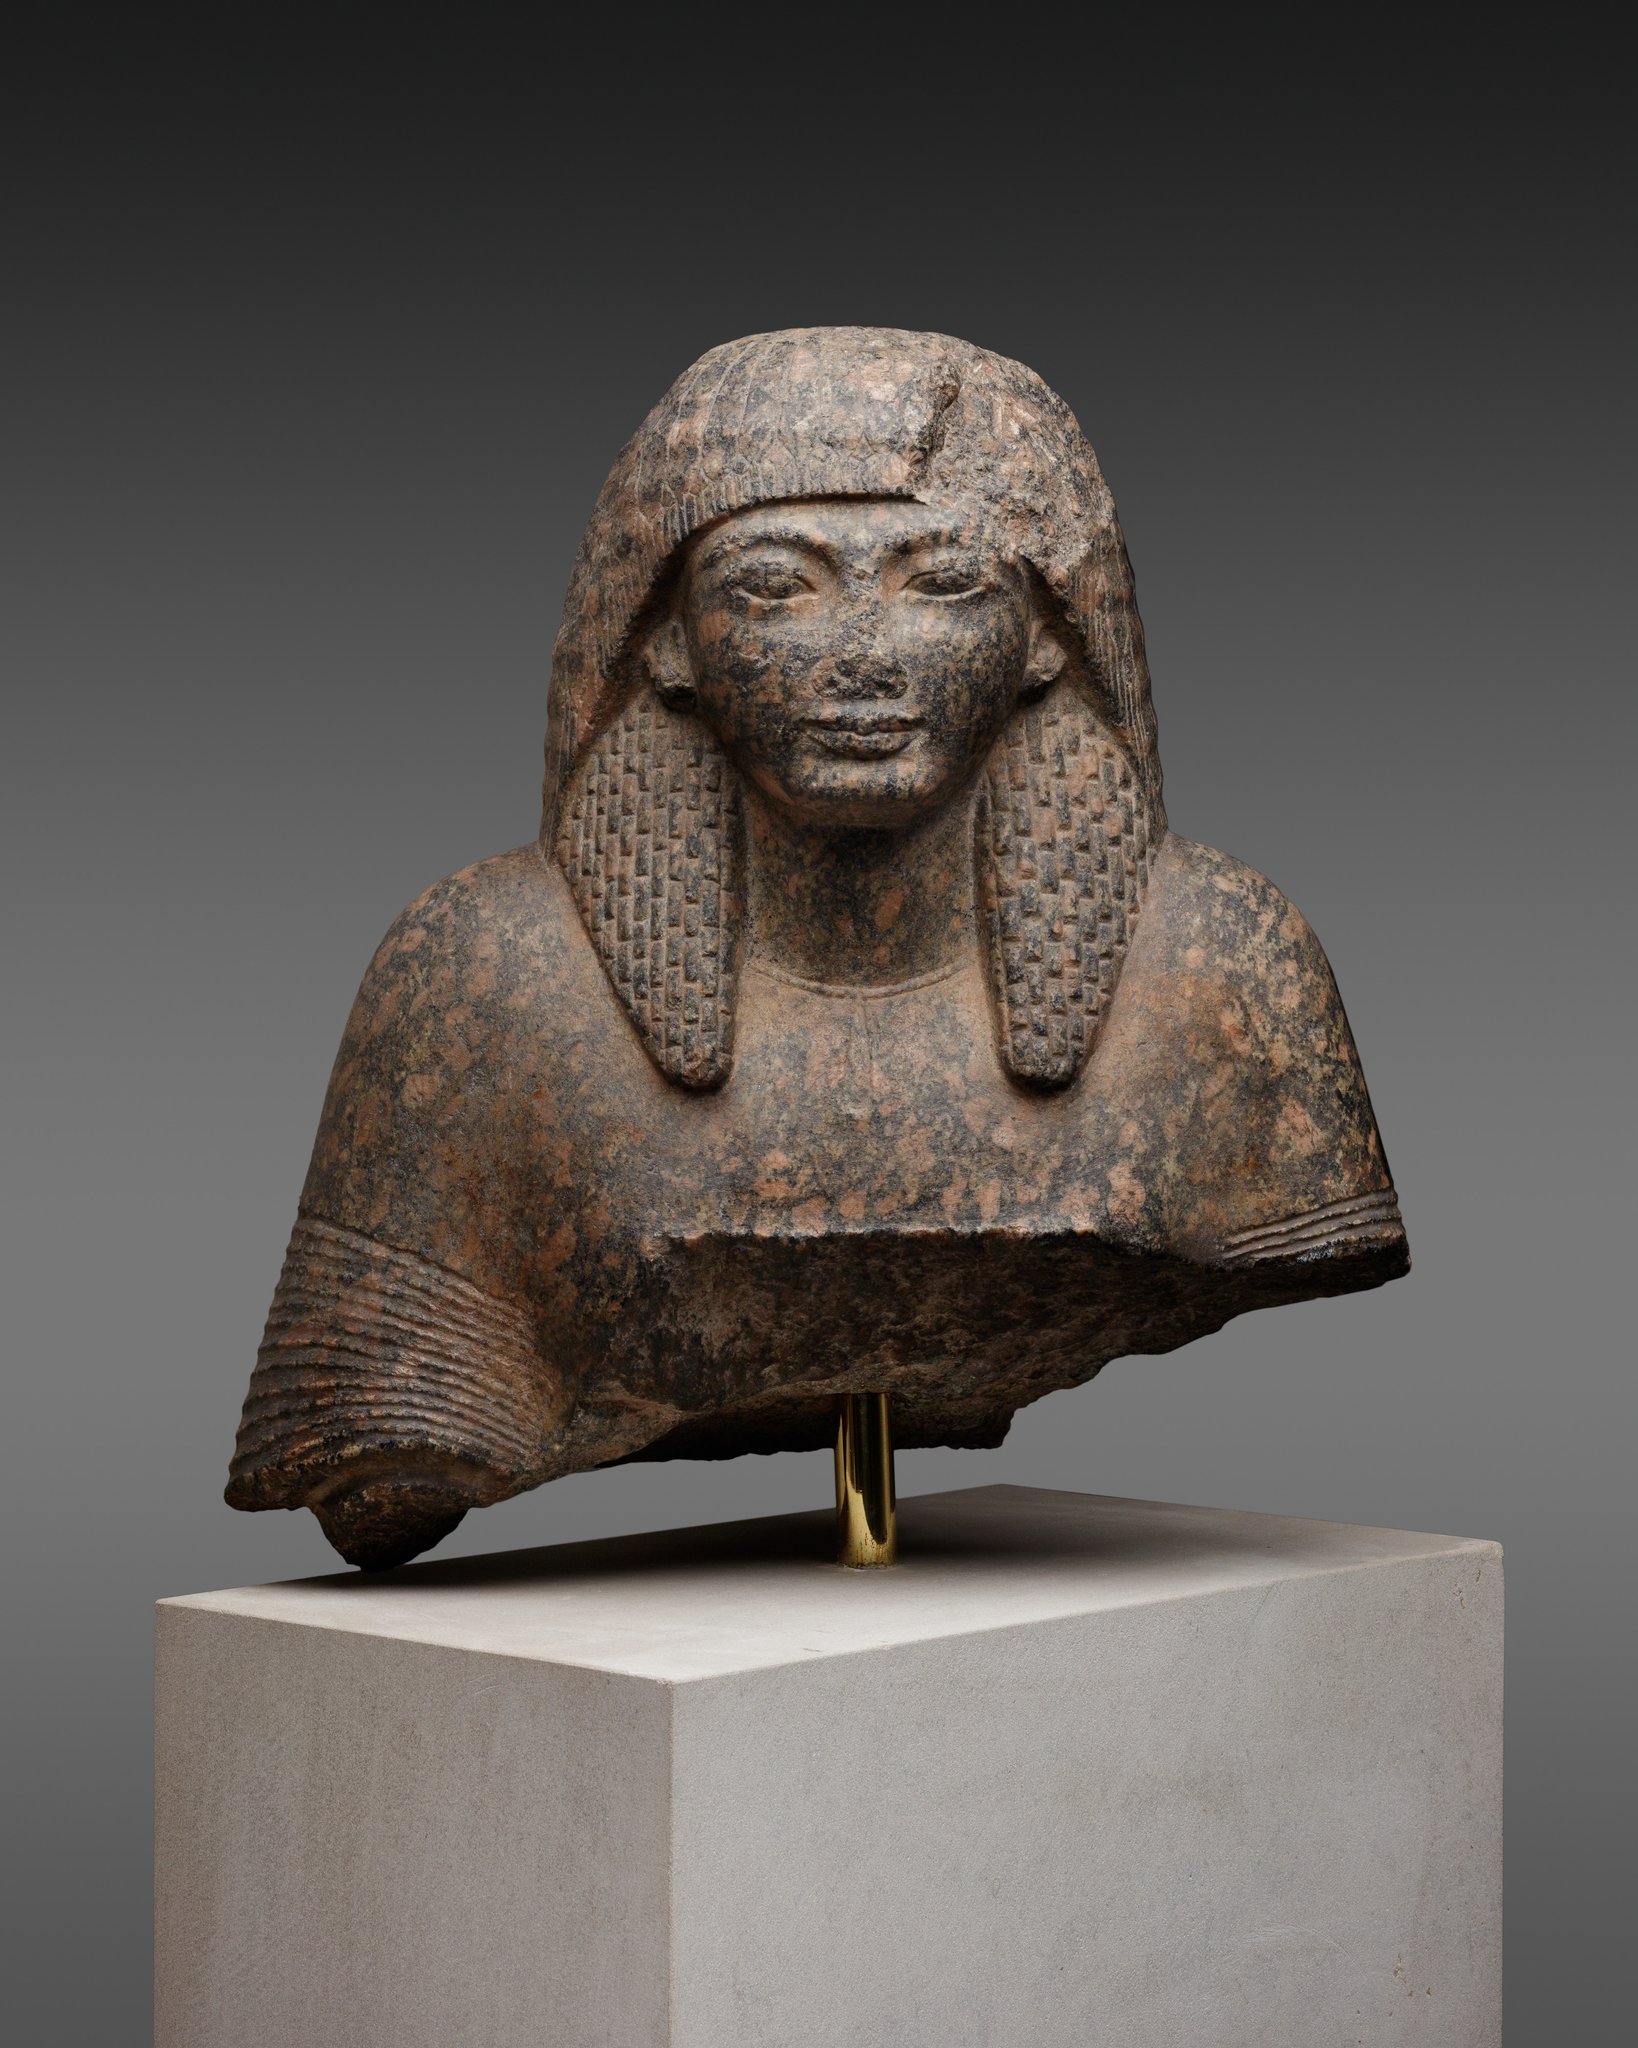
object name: bust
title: Bust of a Naophorous Statue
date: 1301-1200 BCE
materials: granite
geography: egypt